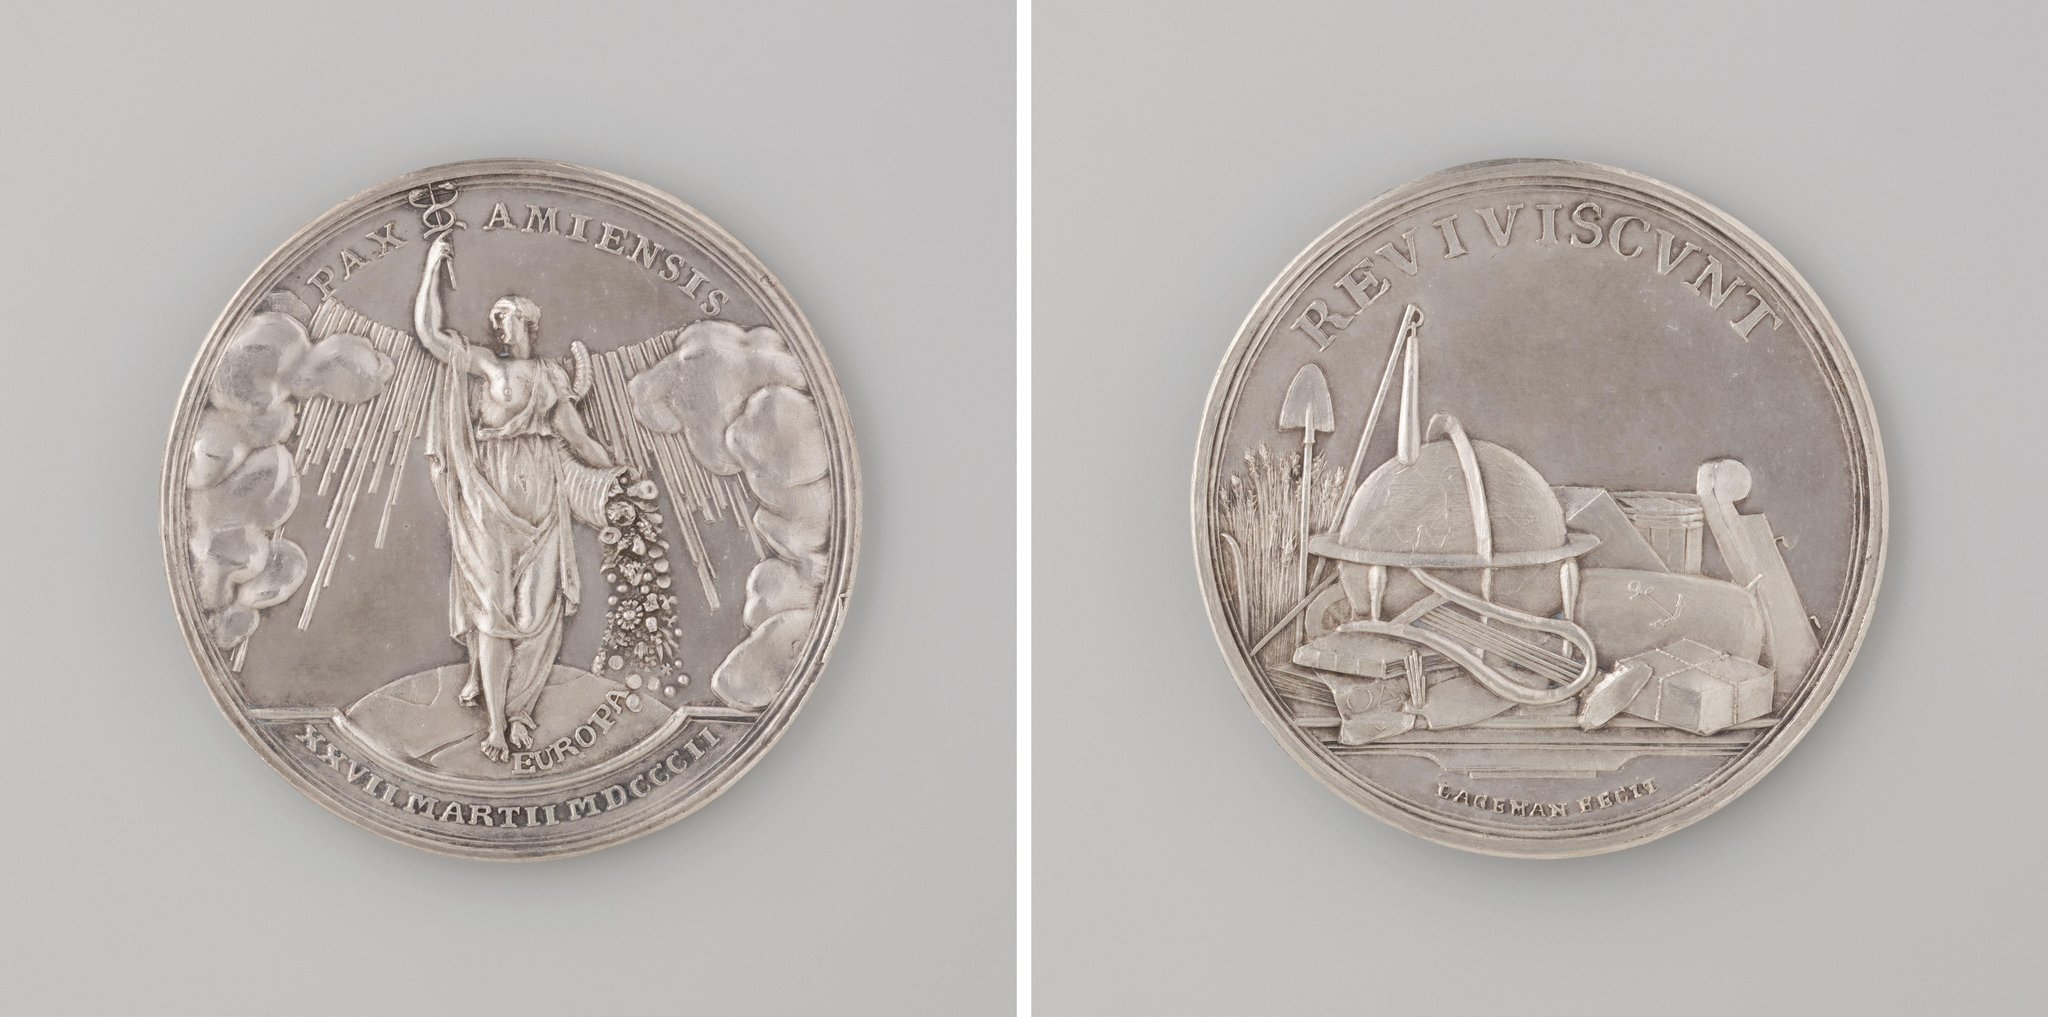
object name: history medal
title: Vrede van Amiens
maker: johannes michiel lageman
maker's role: silversmith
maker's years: 1735-1809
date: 1802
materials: silver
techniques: striking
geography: amsterdam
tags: amiens, vrede van amiens (1802)